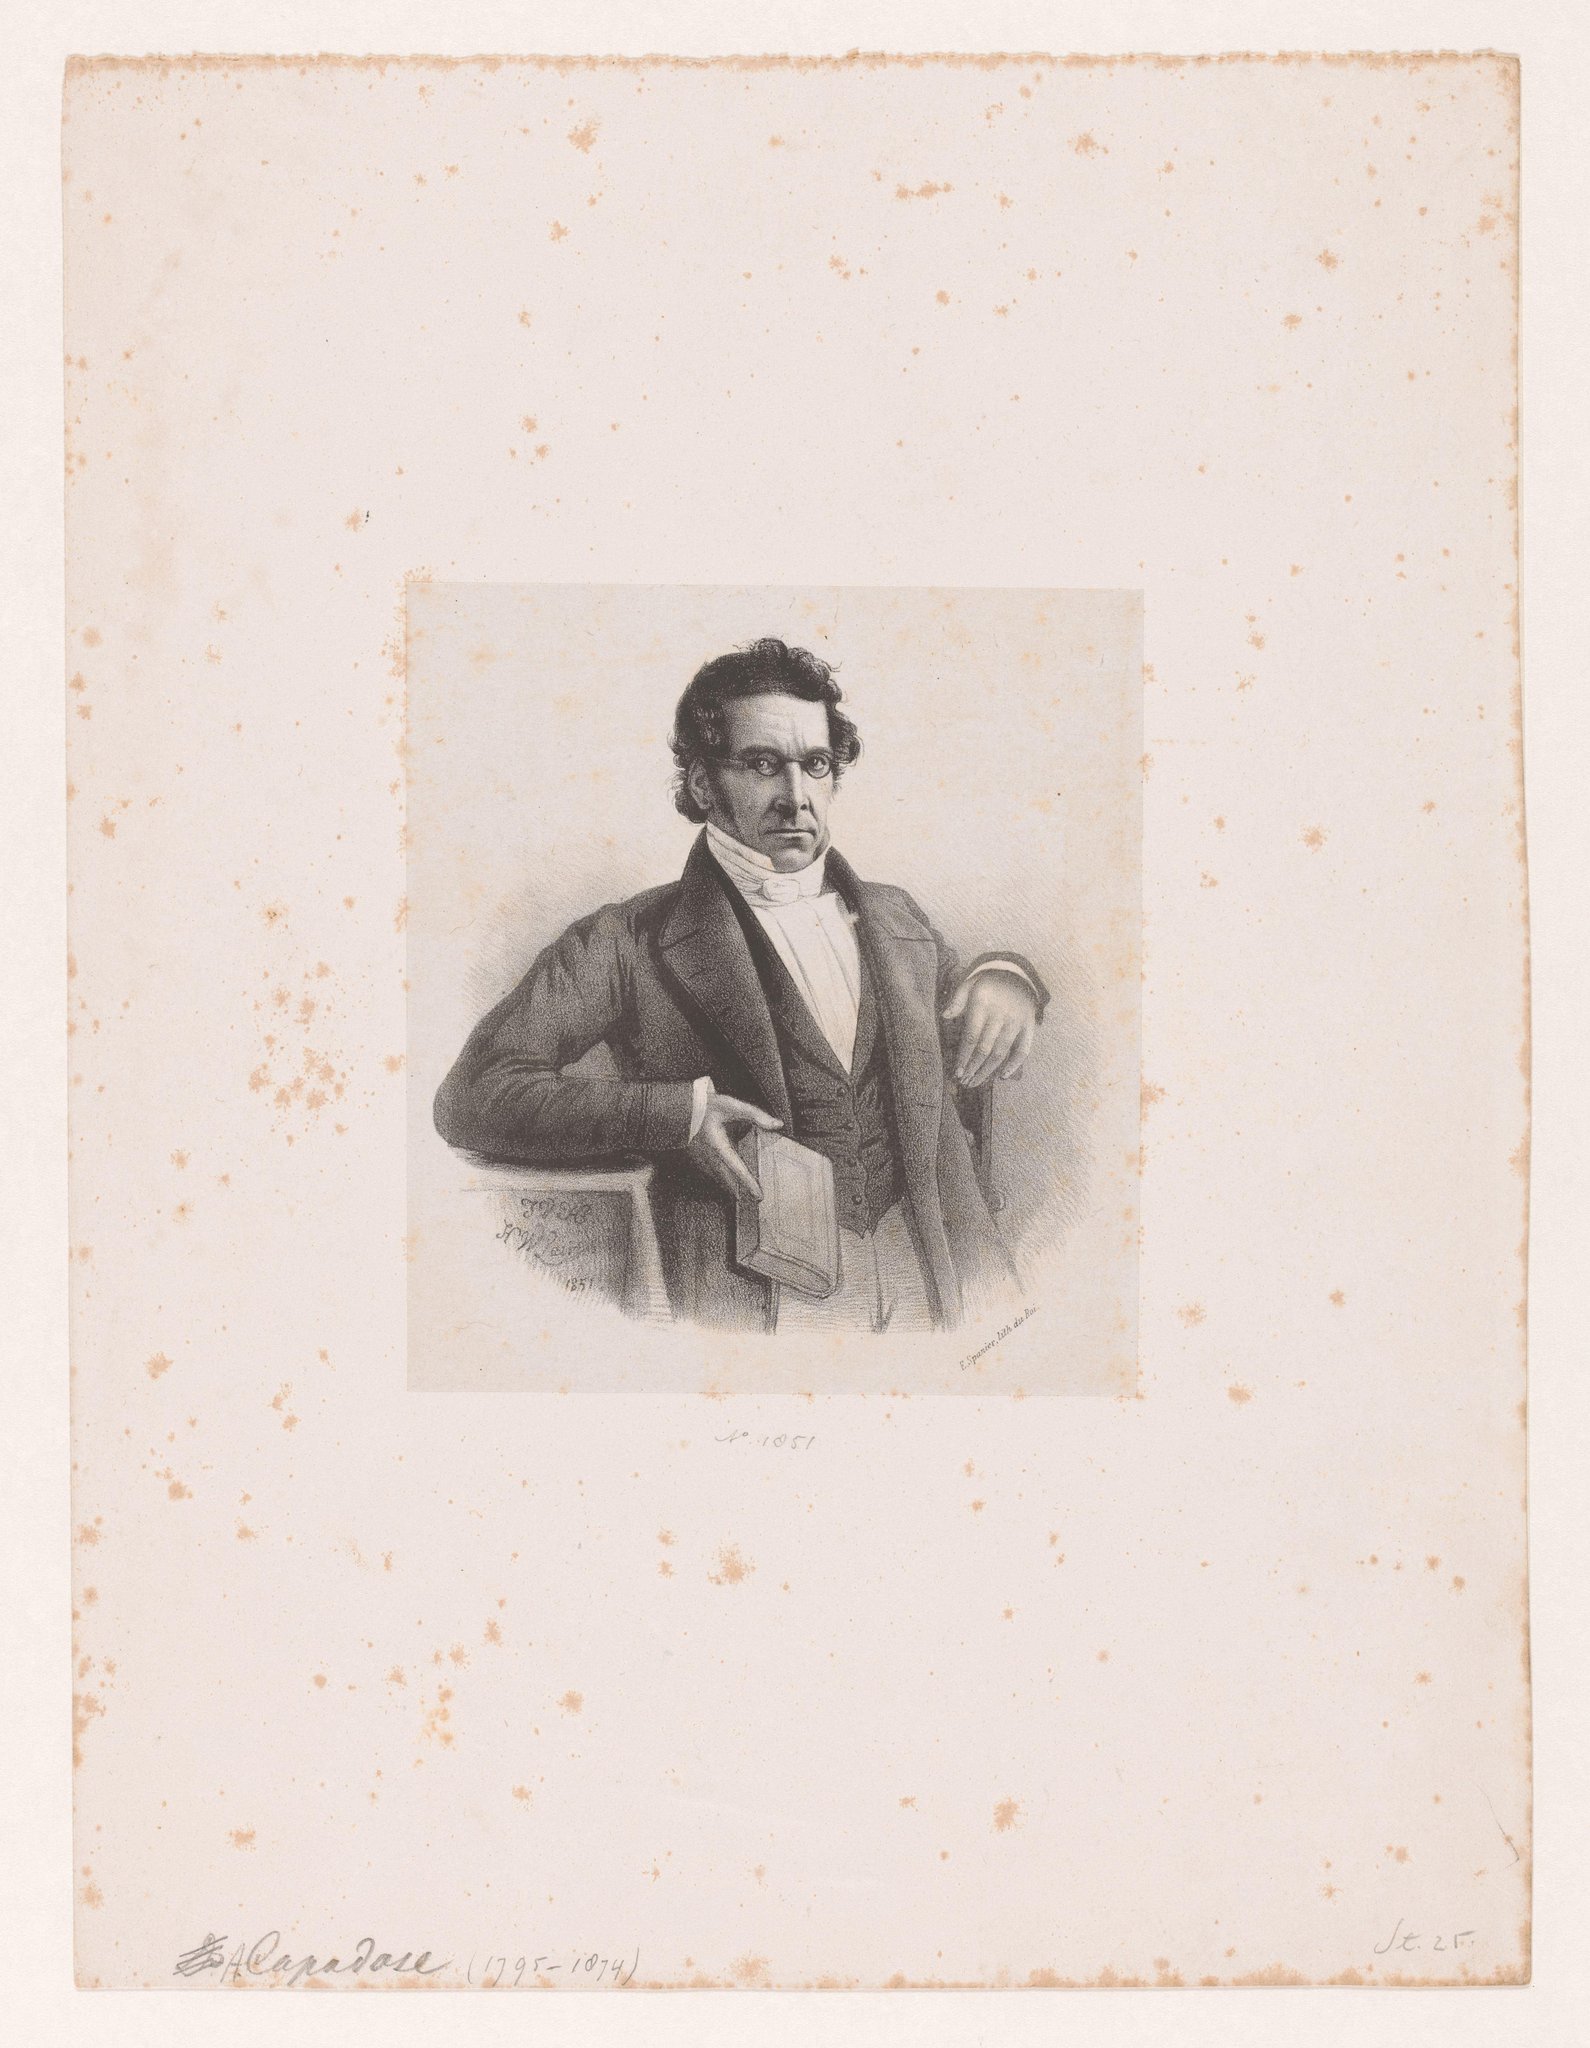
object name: print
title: Portret van Abraham Capadose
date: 1851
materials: paper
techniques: lithograph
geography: the hague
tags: amsterdam, the hague, historical persons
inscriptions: collector's mark: Lugt 2228